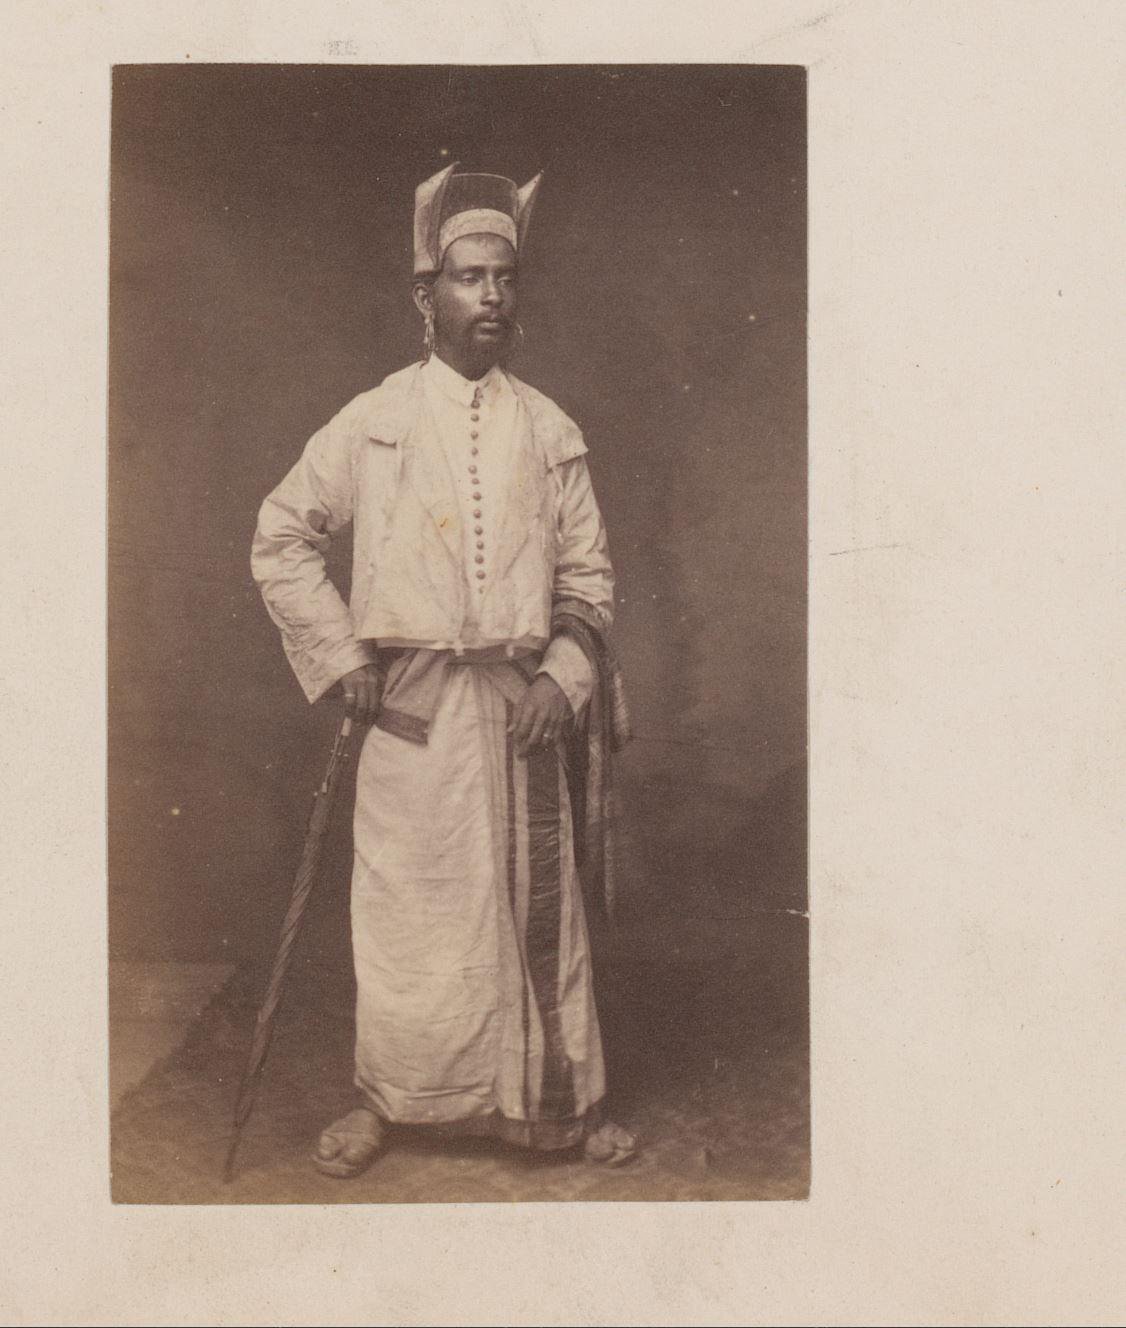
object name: album leaf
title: Portrait of a standing man with umbrella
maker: Anonymous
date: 1880-1900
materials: cardboard, paper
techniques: albumen print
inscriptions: number: ‘1596’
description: Portret van een staande man in een studio. De man draagt een licht gewaad en een hoofddeksel. Object zit samen met de andere foto's met nummer RP-F-00-6678 op één blad geplakt.